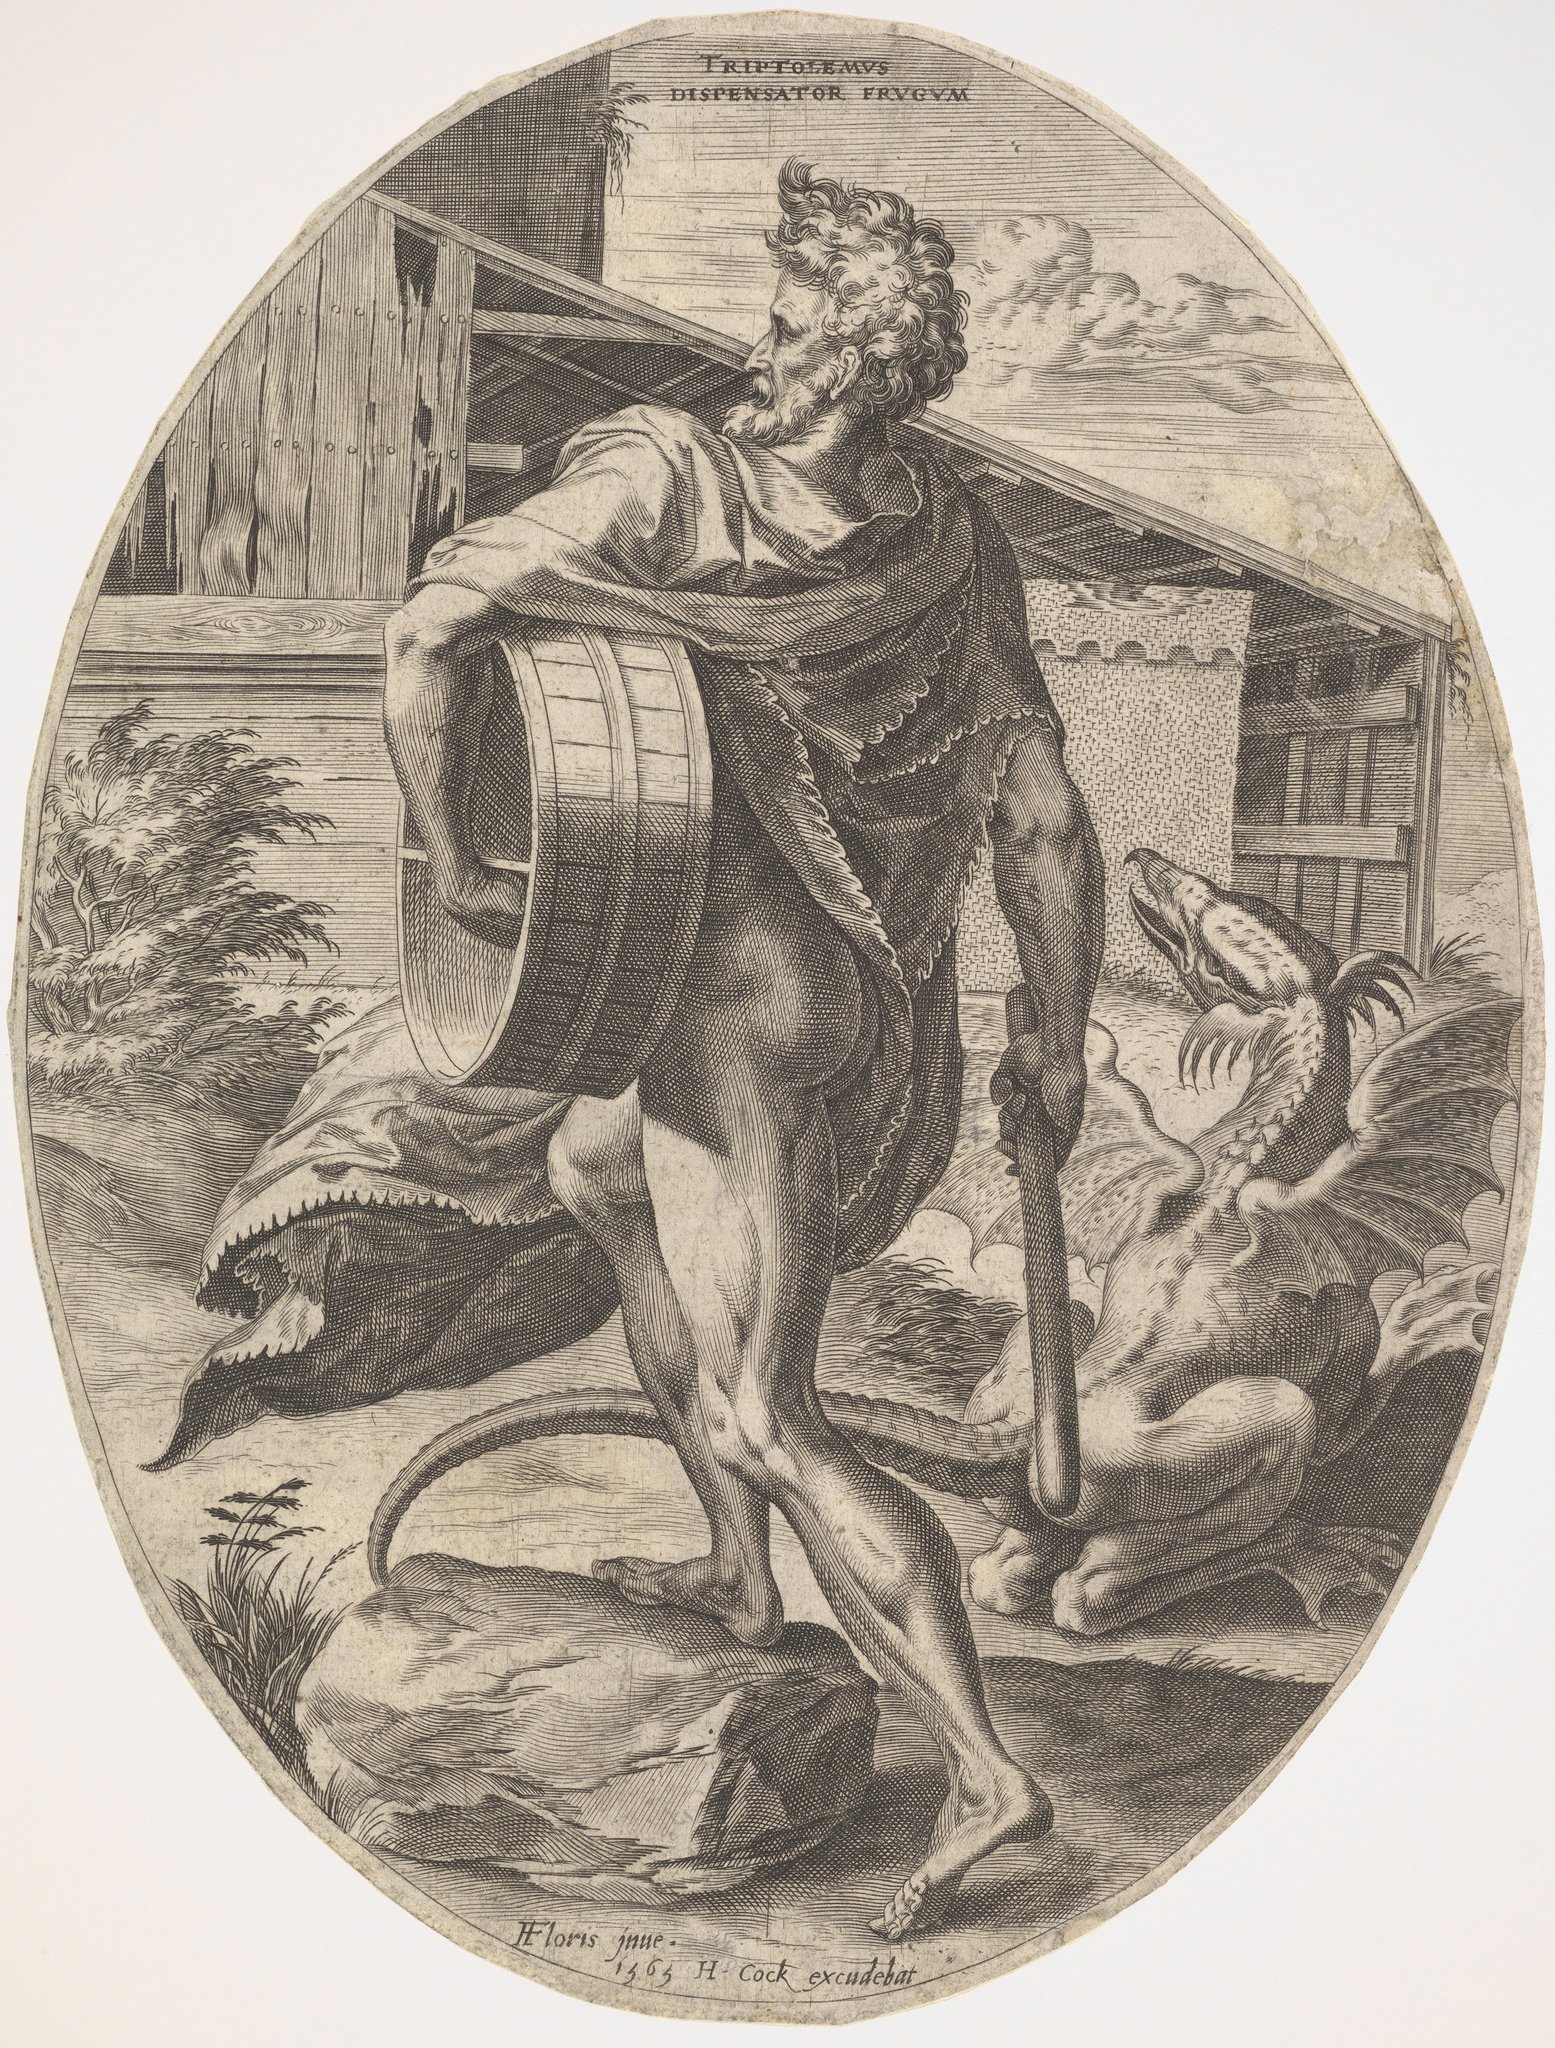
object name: print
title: Triptolemus, from "The Rural Gods"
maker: cornelis cort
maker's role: artist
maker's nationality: netherlandish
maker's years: 1533-1578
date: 1565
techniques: engraving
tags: men,dragons